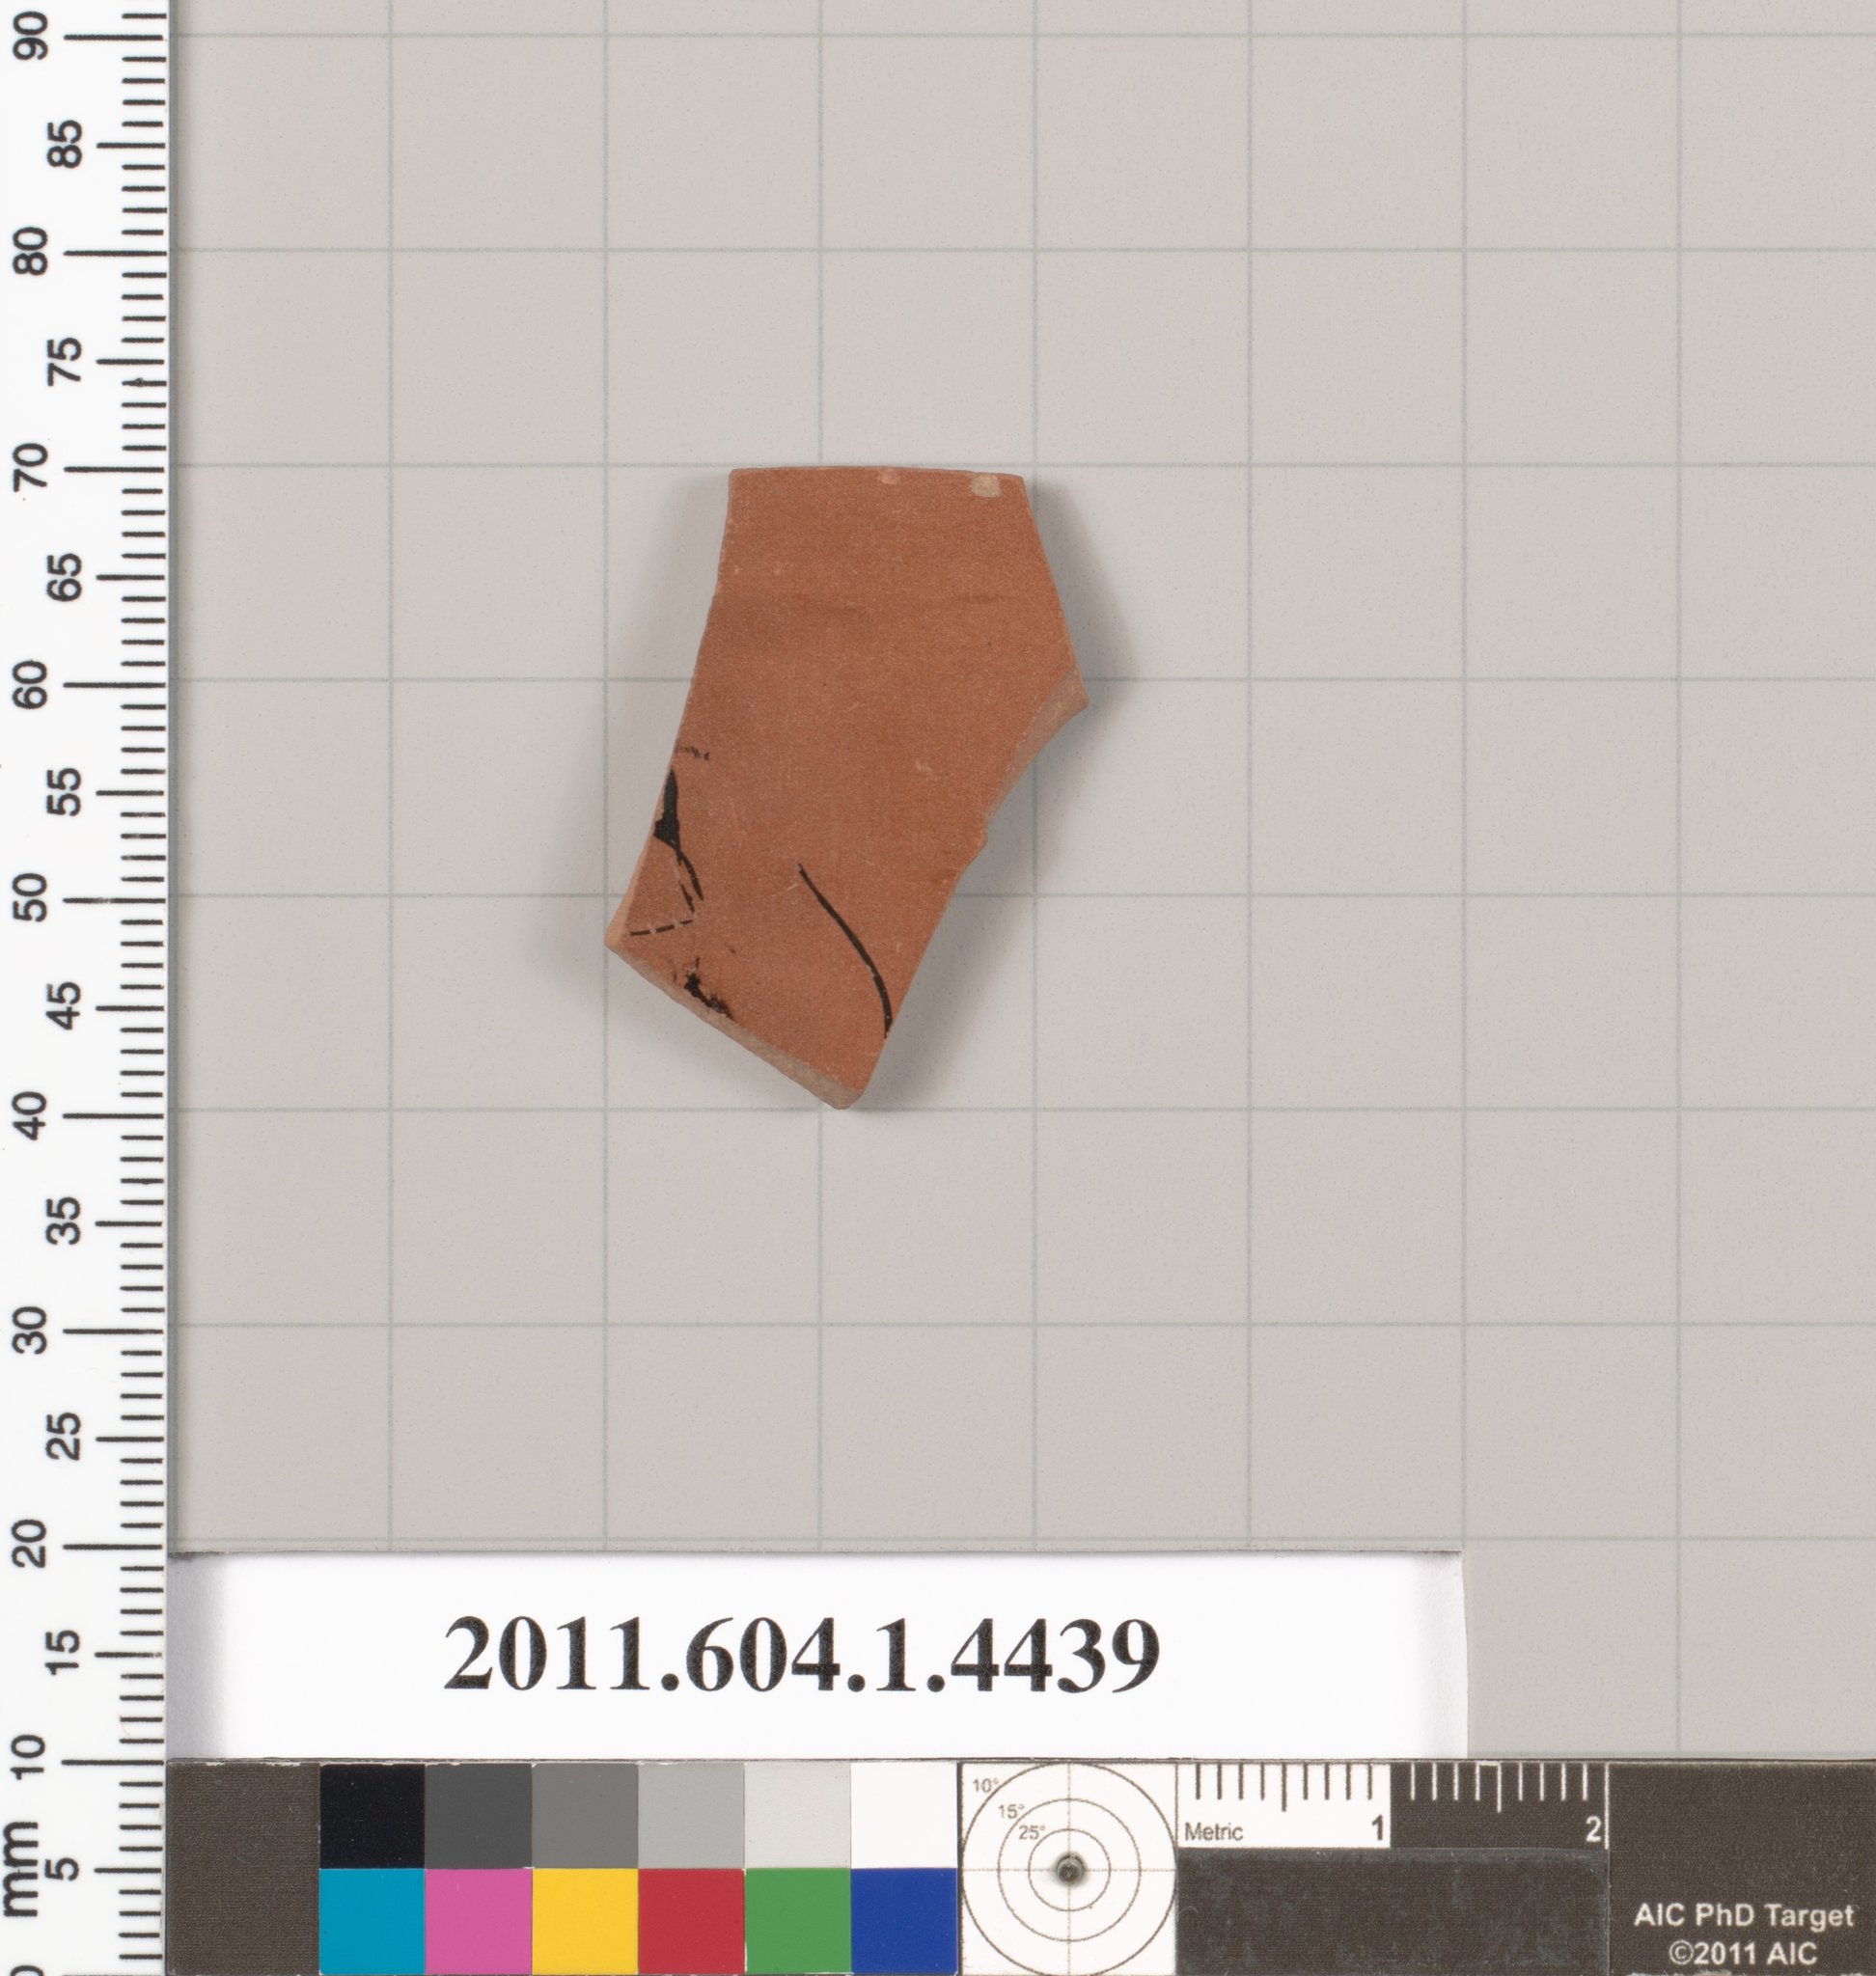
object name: kylix fragment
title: Terracotta fragment of a kylix (drinking cup)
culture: greek, attic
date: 475-451 BCE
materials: terracotta